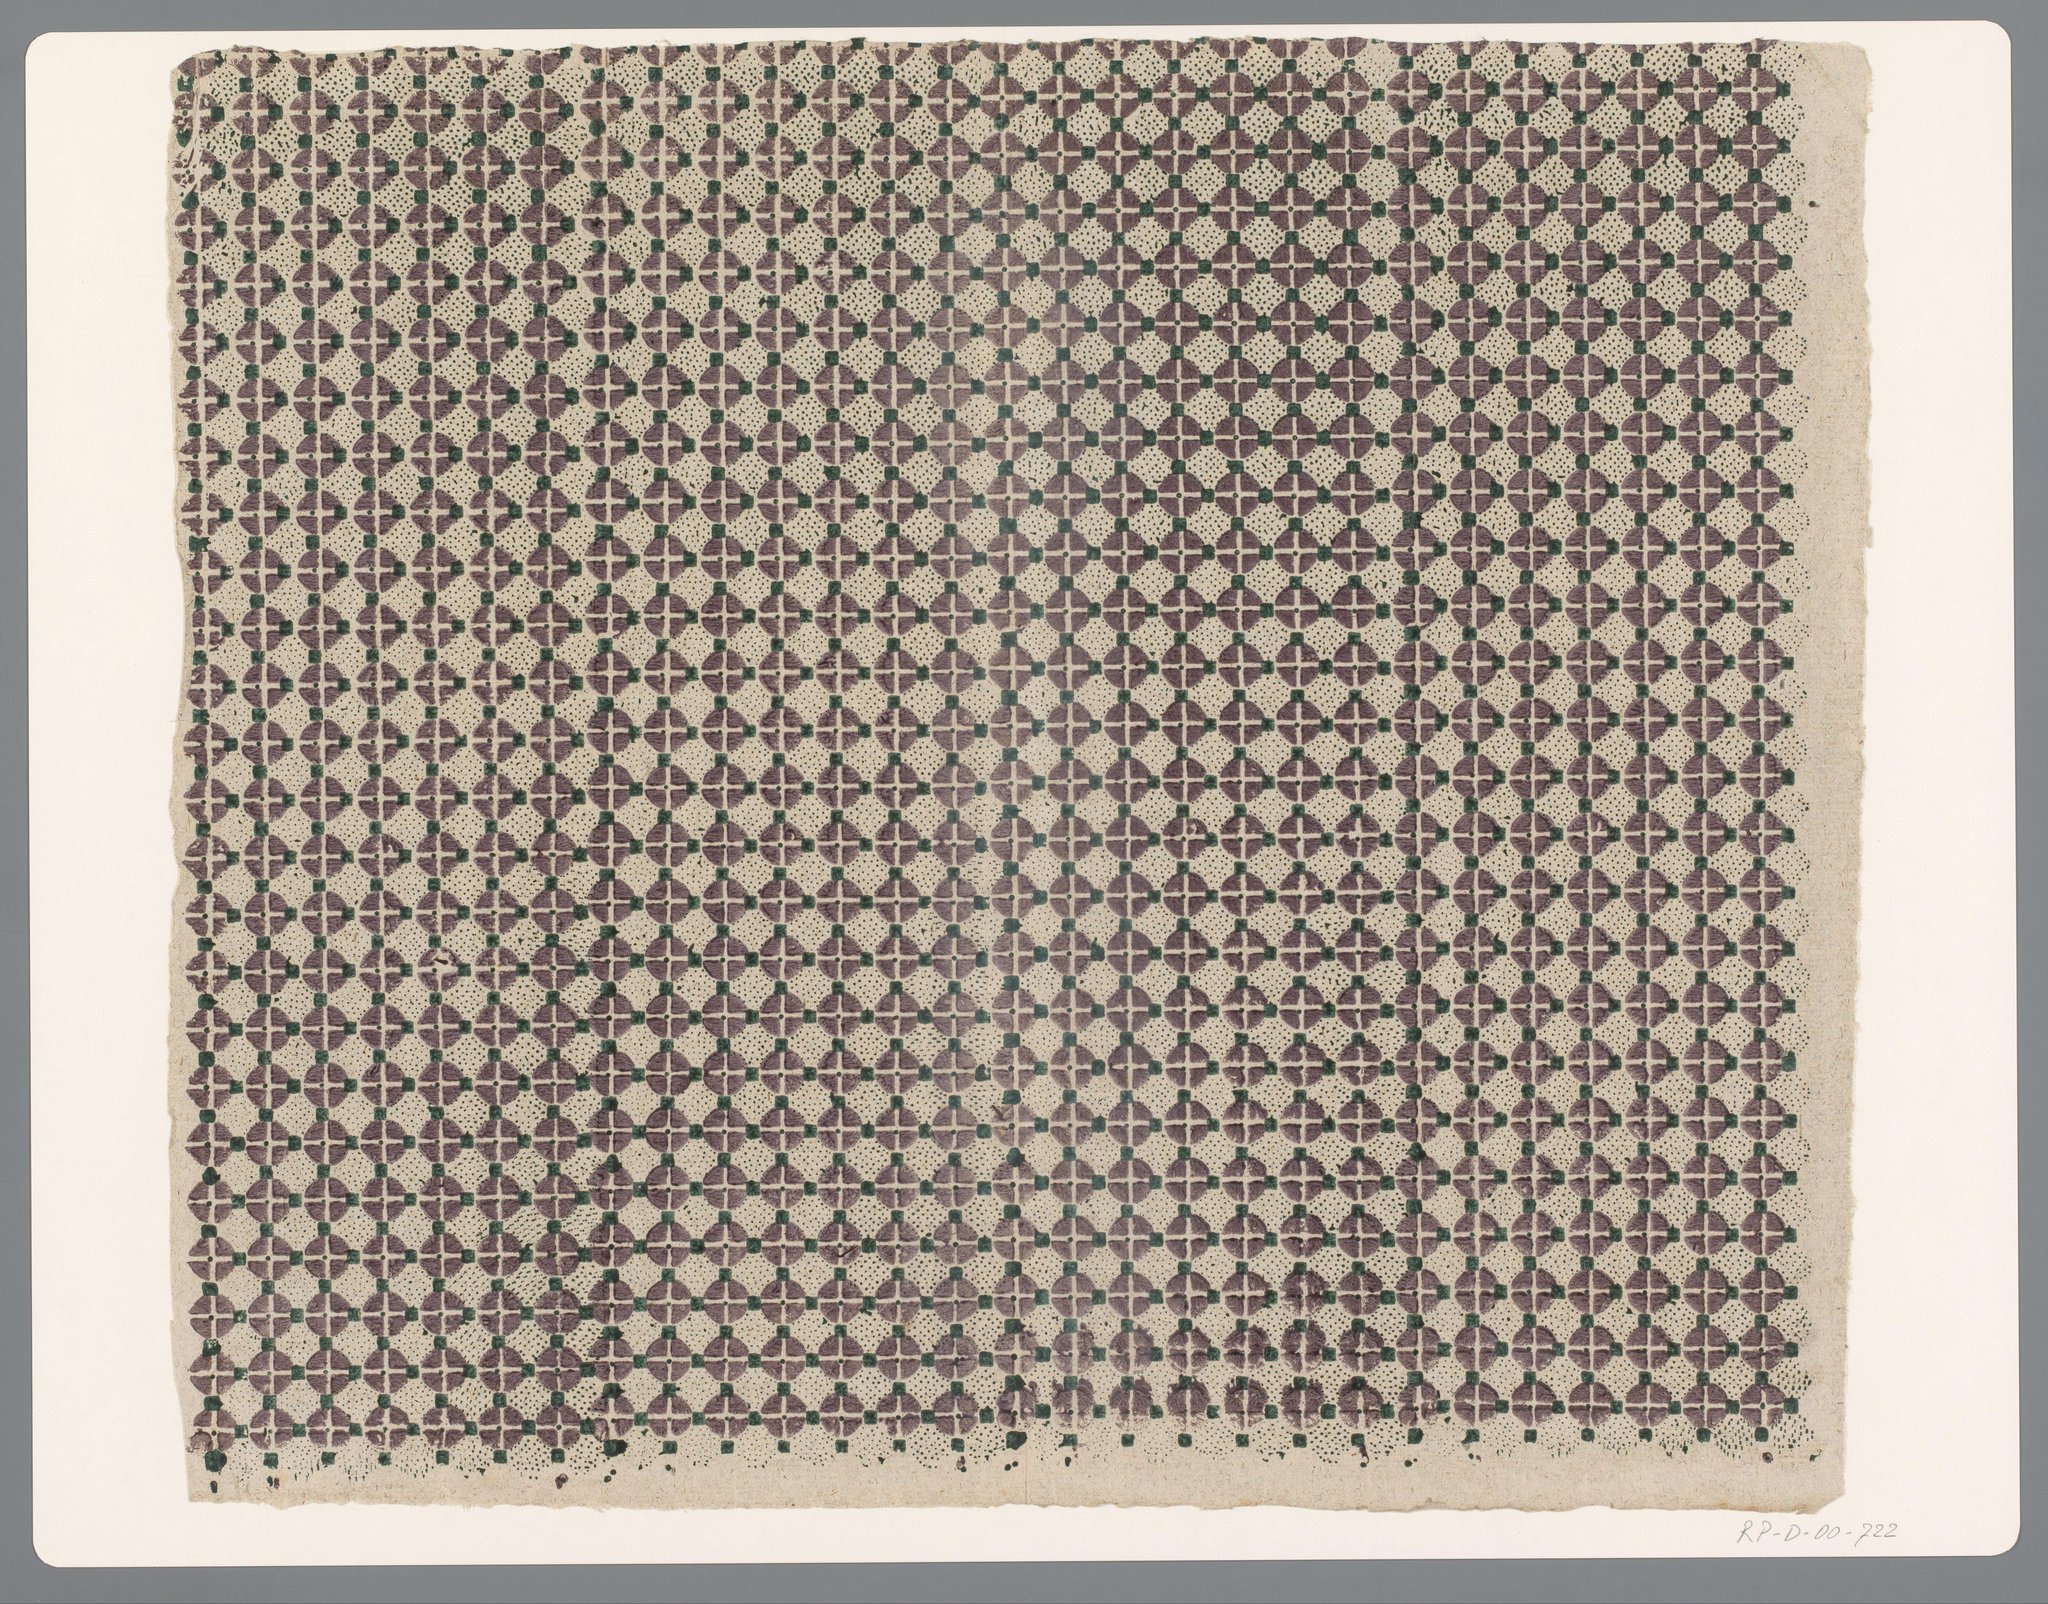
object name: printed paper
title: Blad met banenpatroon van rond motief met kruis tussen blokjes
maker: Anonymous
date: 1750-1900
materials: lacquer, paper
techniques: printing block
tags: ornament ~ round and curved forms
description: Blad met banenpatroon van rond motief met kruis tussen blokjes met puntenfond.